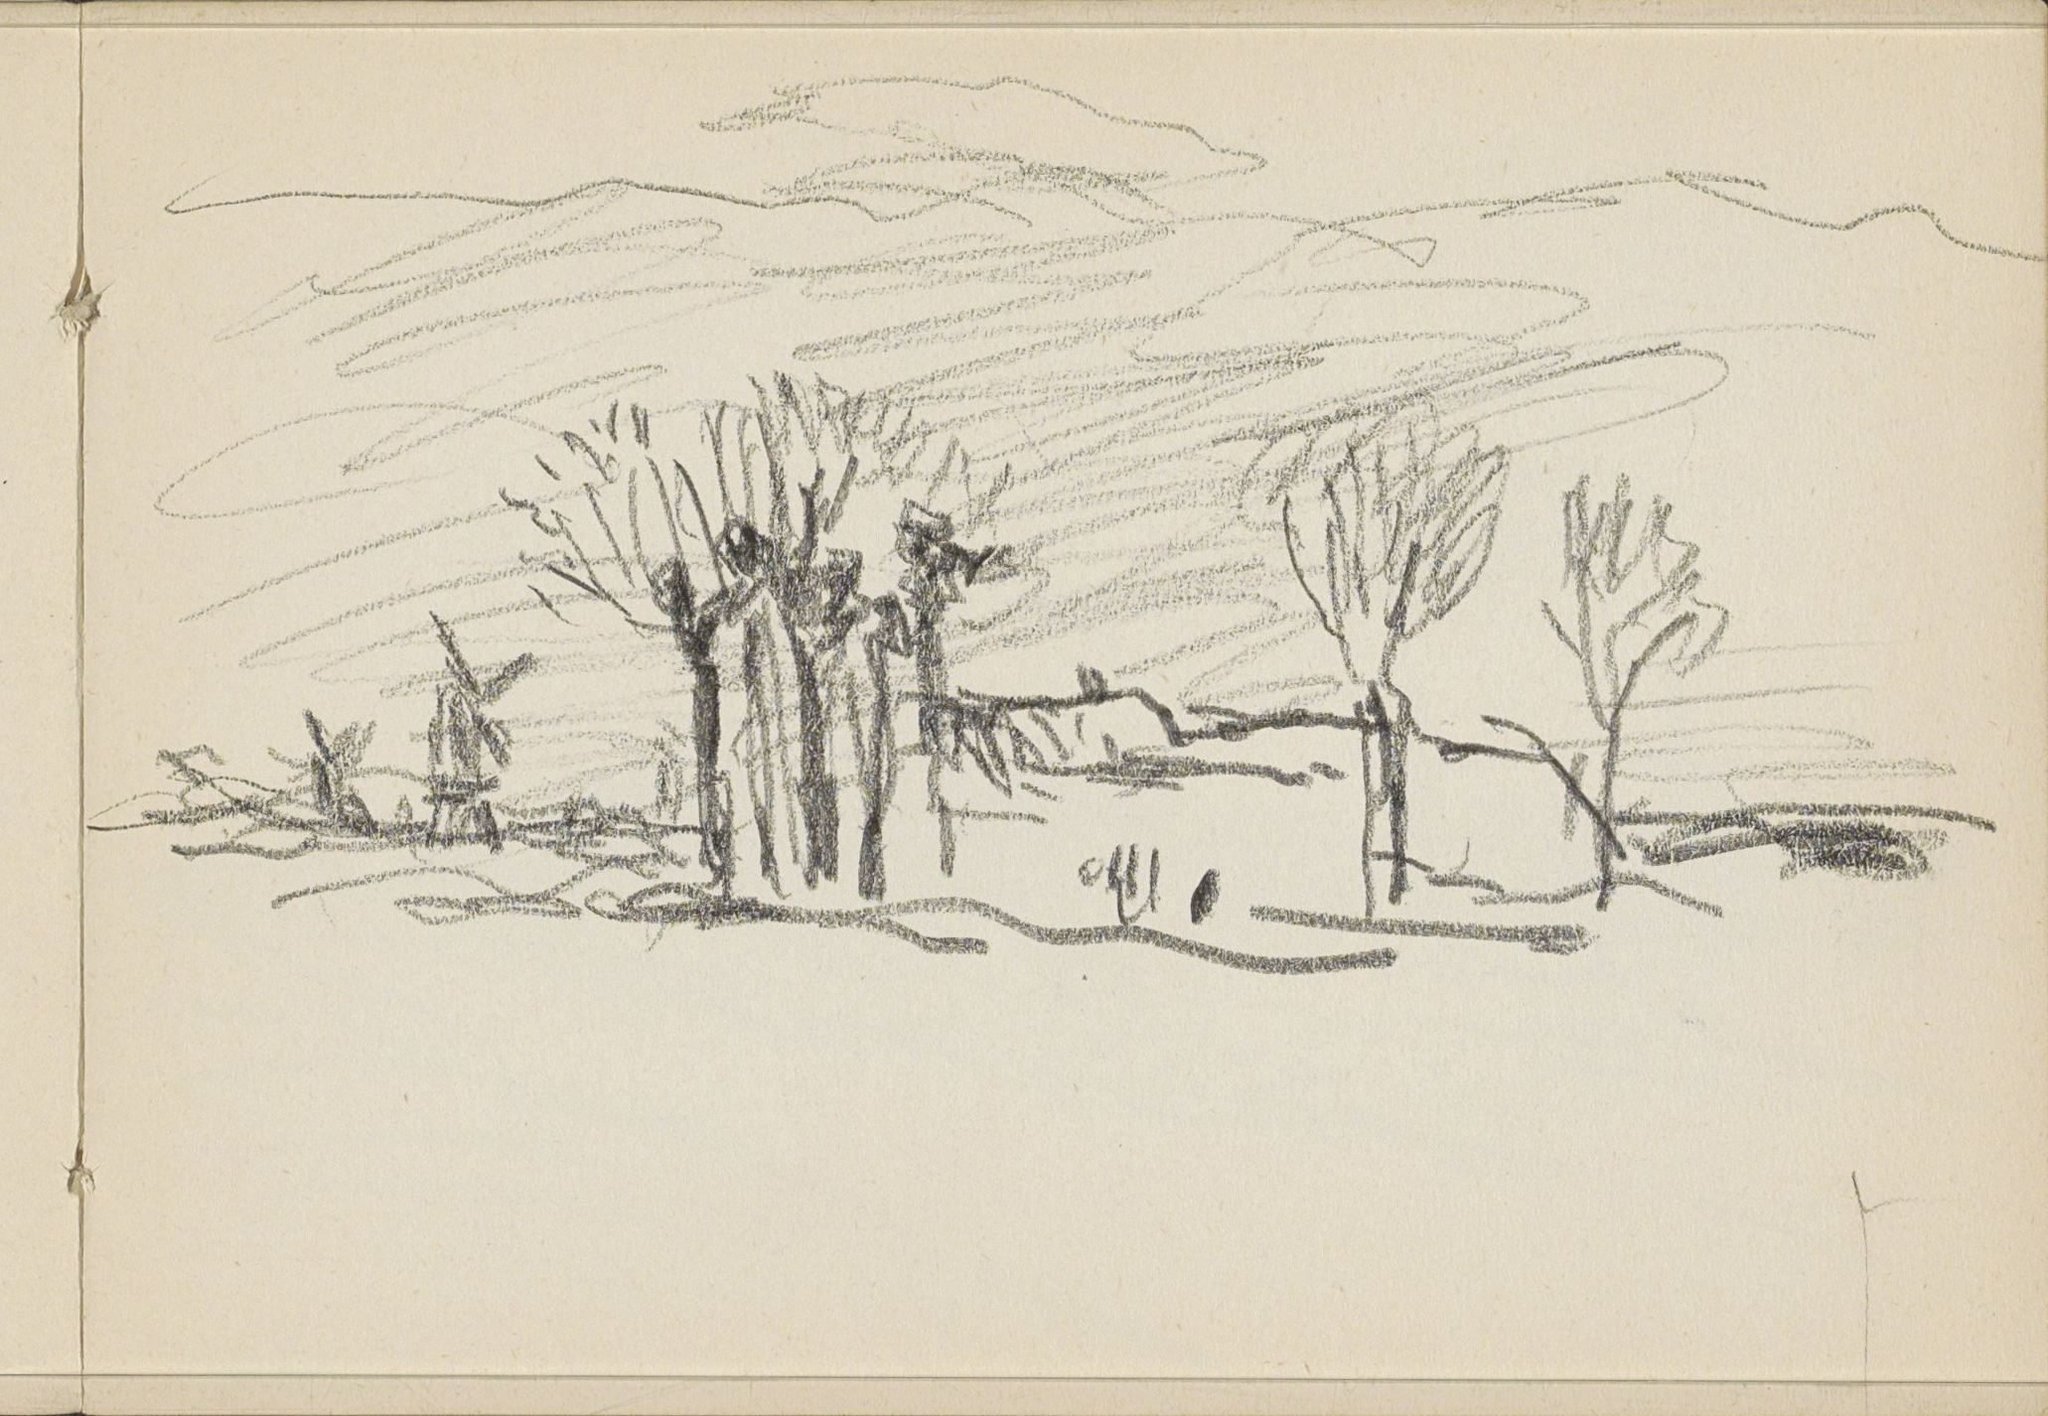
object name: sketchbook leaf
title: Landschap met knotwilgen en molens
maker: alexander shilling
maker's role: draughtsman, print maker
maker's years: 1859-1937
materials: chalk, paper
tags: trees, windmill in landscape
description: Blad 21 recto uit een schetsboek met 30 bladen.